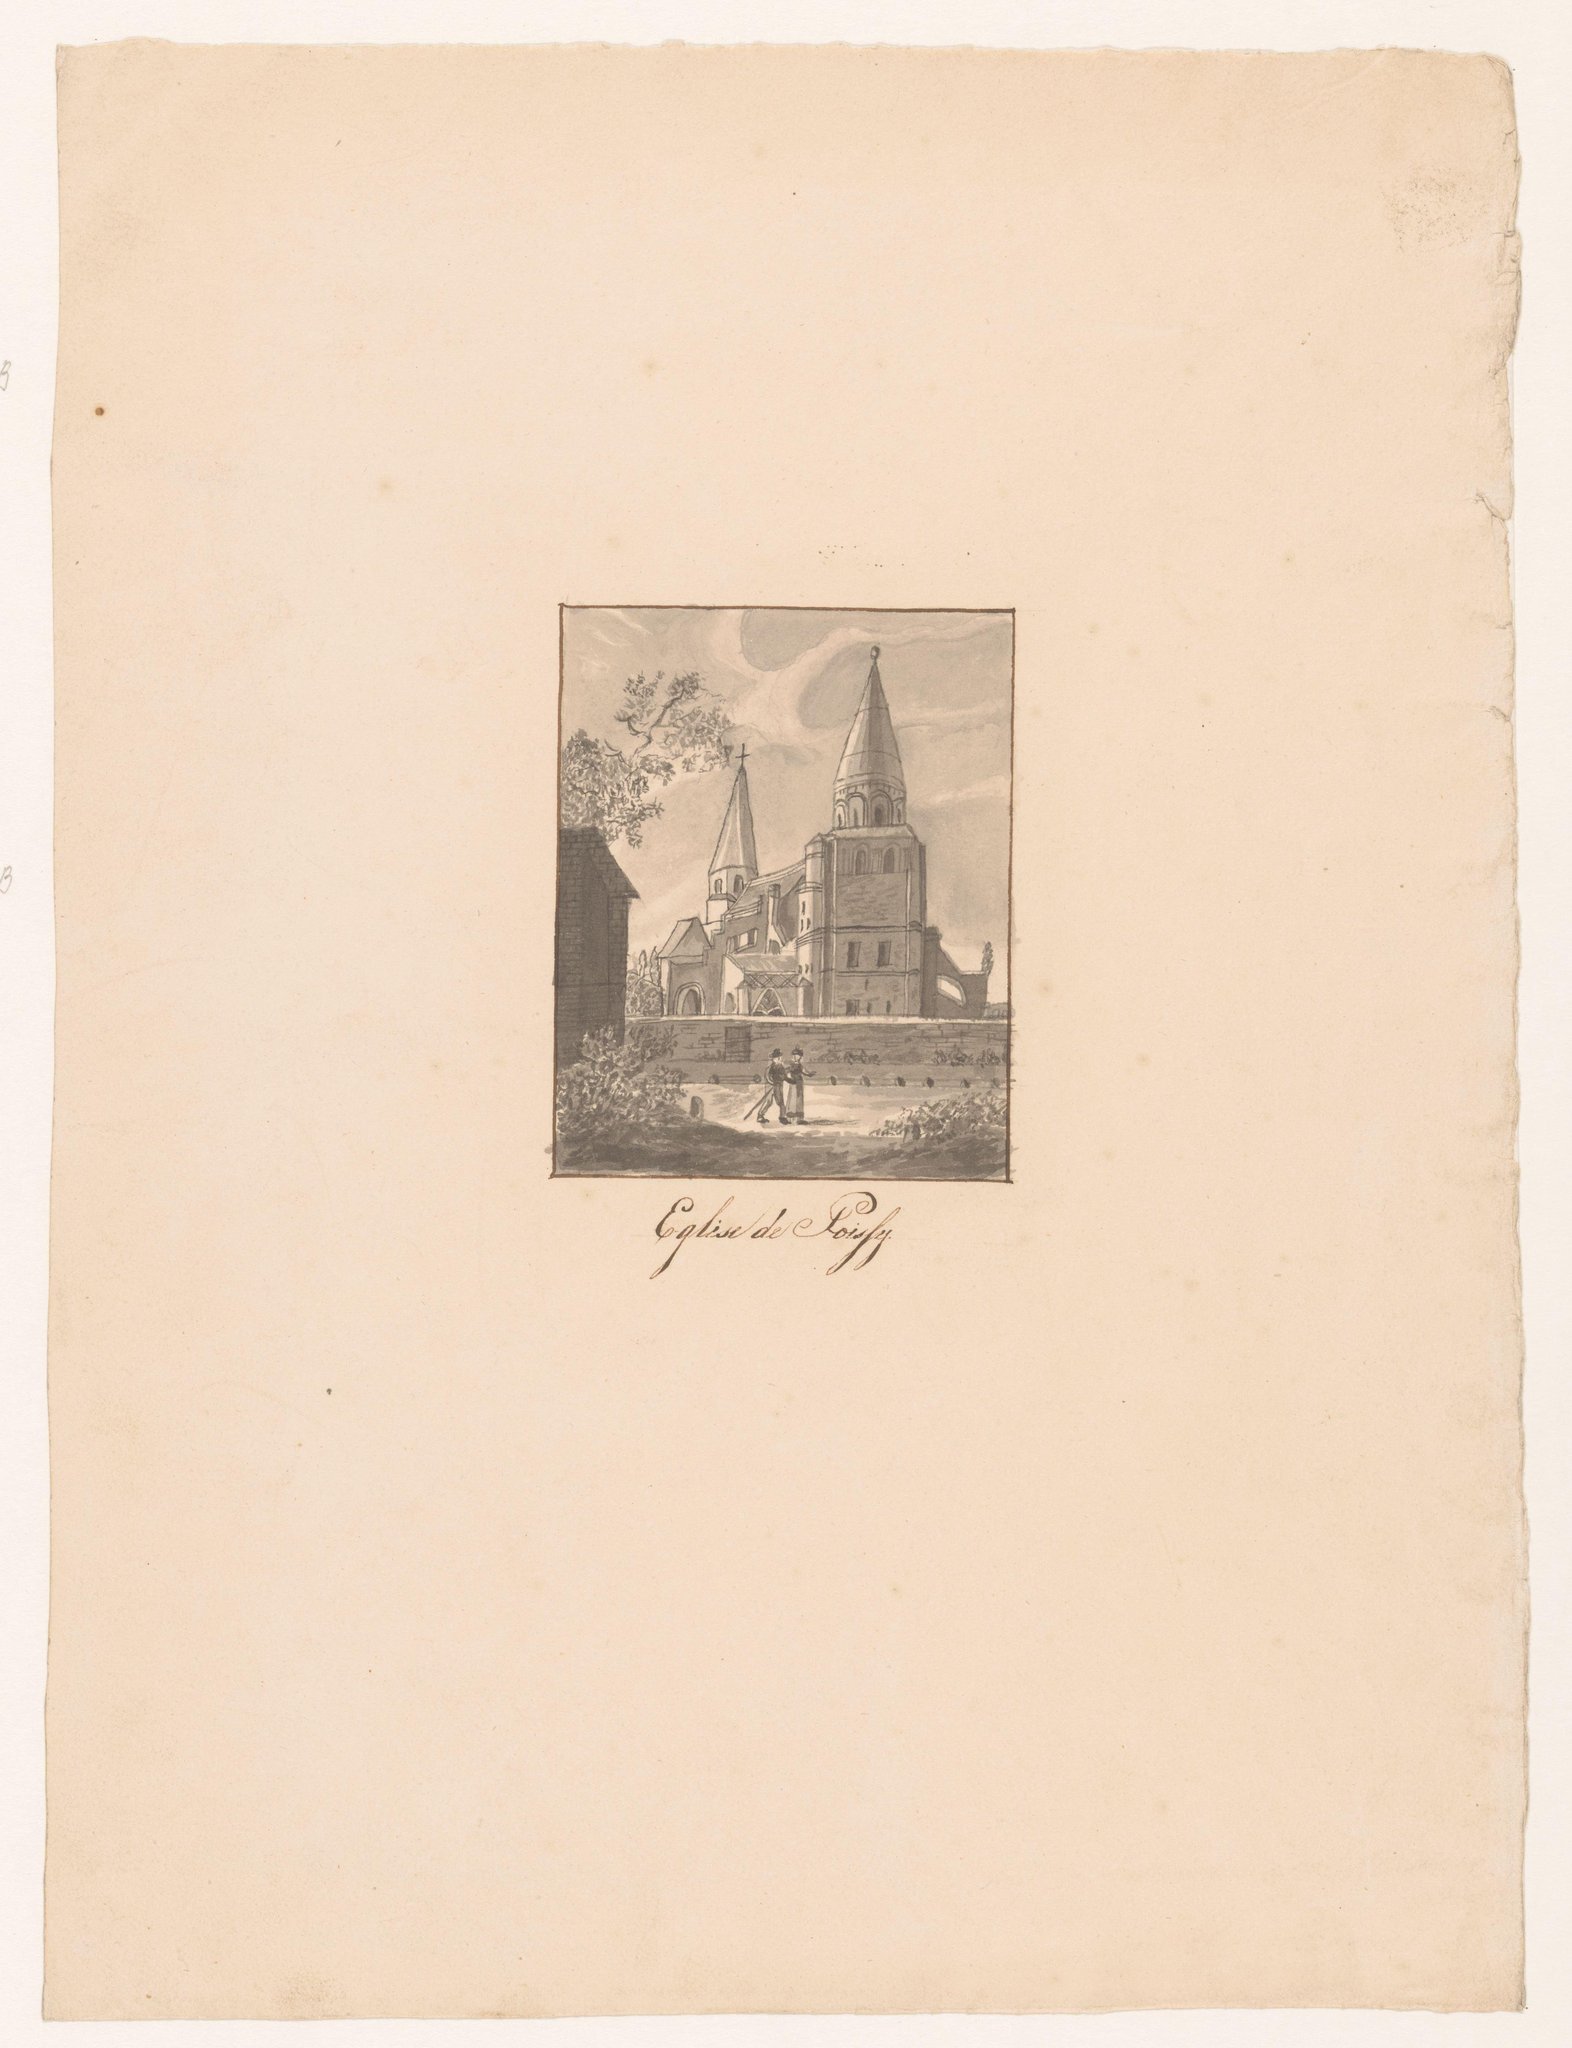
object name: drawing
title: Gezicht op een kerk te Poissy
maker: Anonymous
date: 1650-1750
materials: ink, paper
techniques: brush, pen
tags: roman catholic church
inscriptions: collector's mark: Lugt 2228